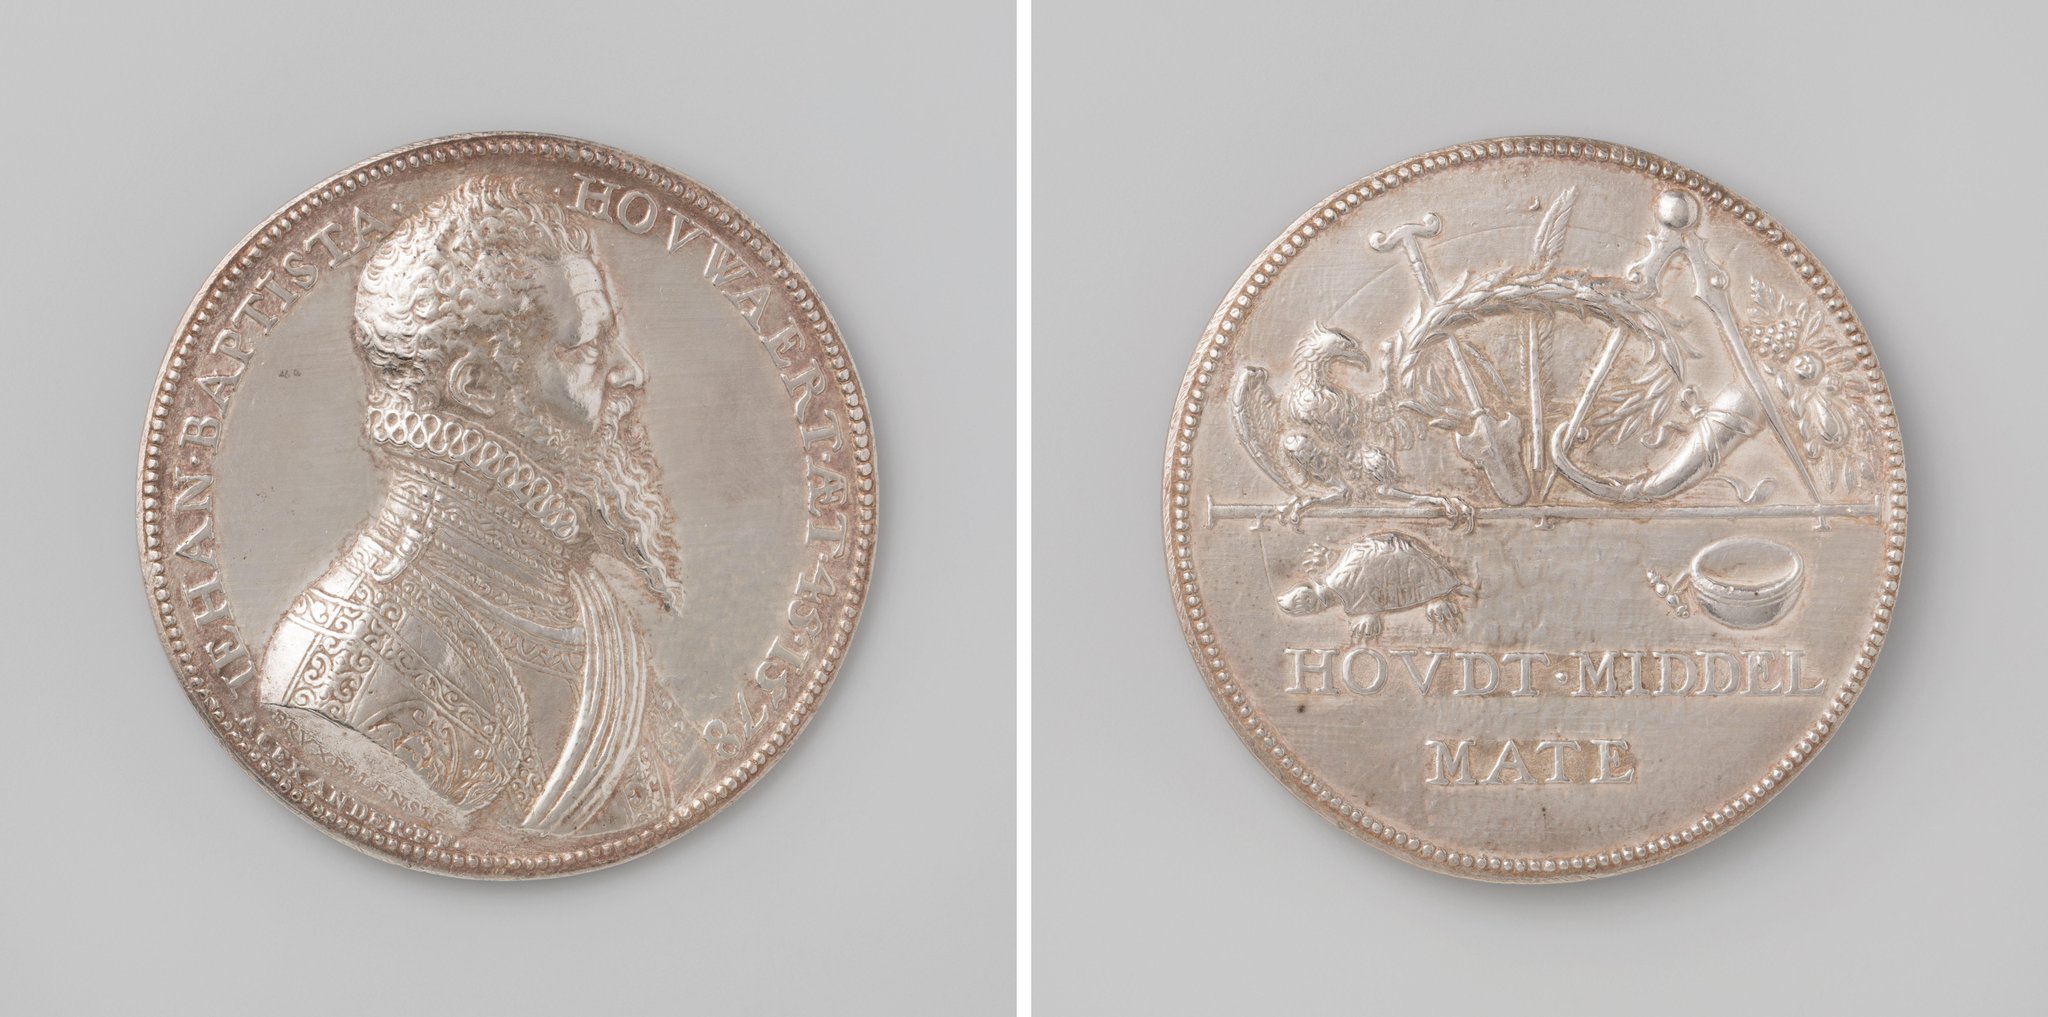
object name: history medal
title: Jan Baptist Houwaert, raadsheer en meester van de Rekenkamer van de Koning te Brussel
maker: pater alexander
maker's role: medailleur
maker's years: 1520-1578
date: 1578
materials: silver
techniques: casting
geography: brussels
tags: jan baptist houwaert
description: Zilveren penning. Voorzijde: borststuk man binnen omschrift. Keerzijde: spade, schrijfveer en passer binnen lauwerkrans; binnen door passer getrokken cirkel, die door meetlat in tweeen gedeeld wordt: boven een arend en een hoorn van overvloed, onder een schildpad en een bedelnap boven opschrift.